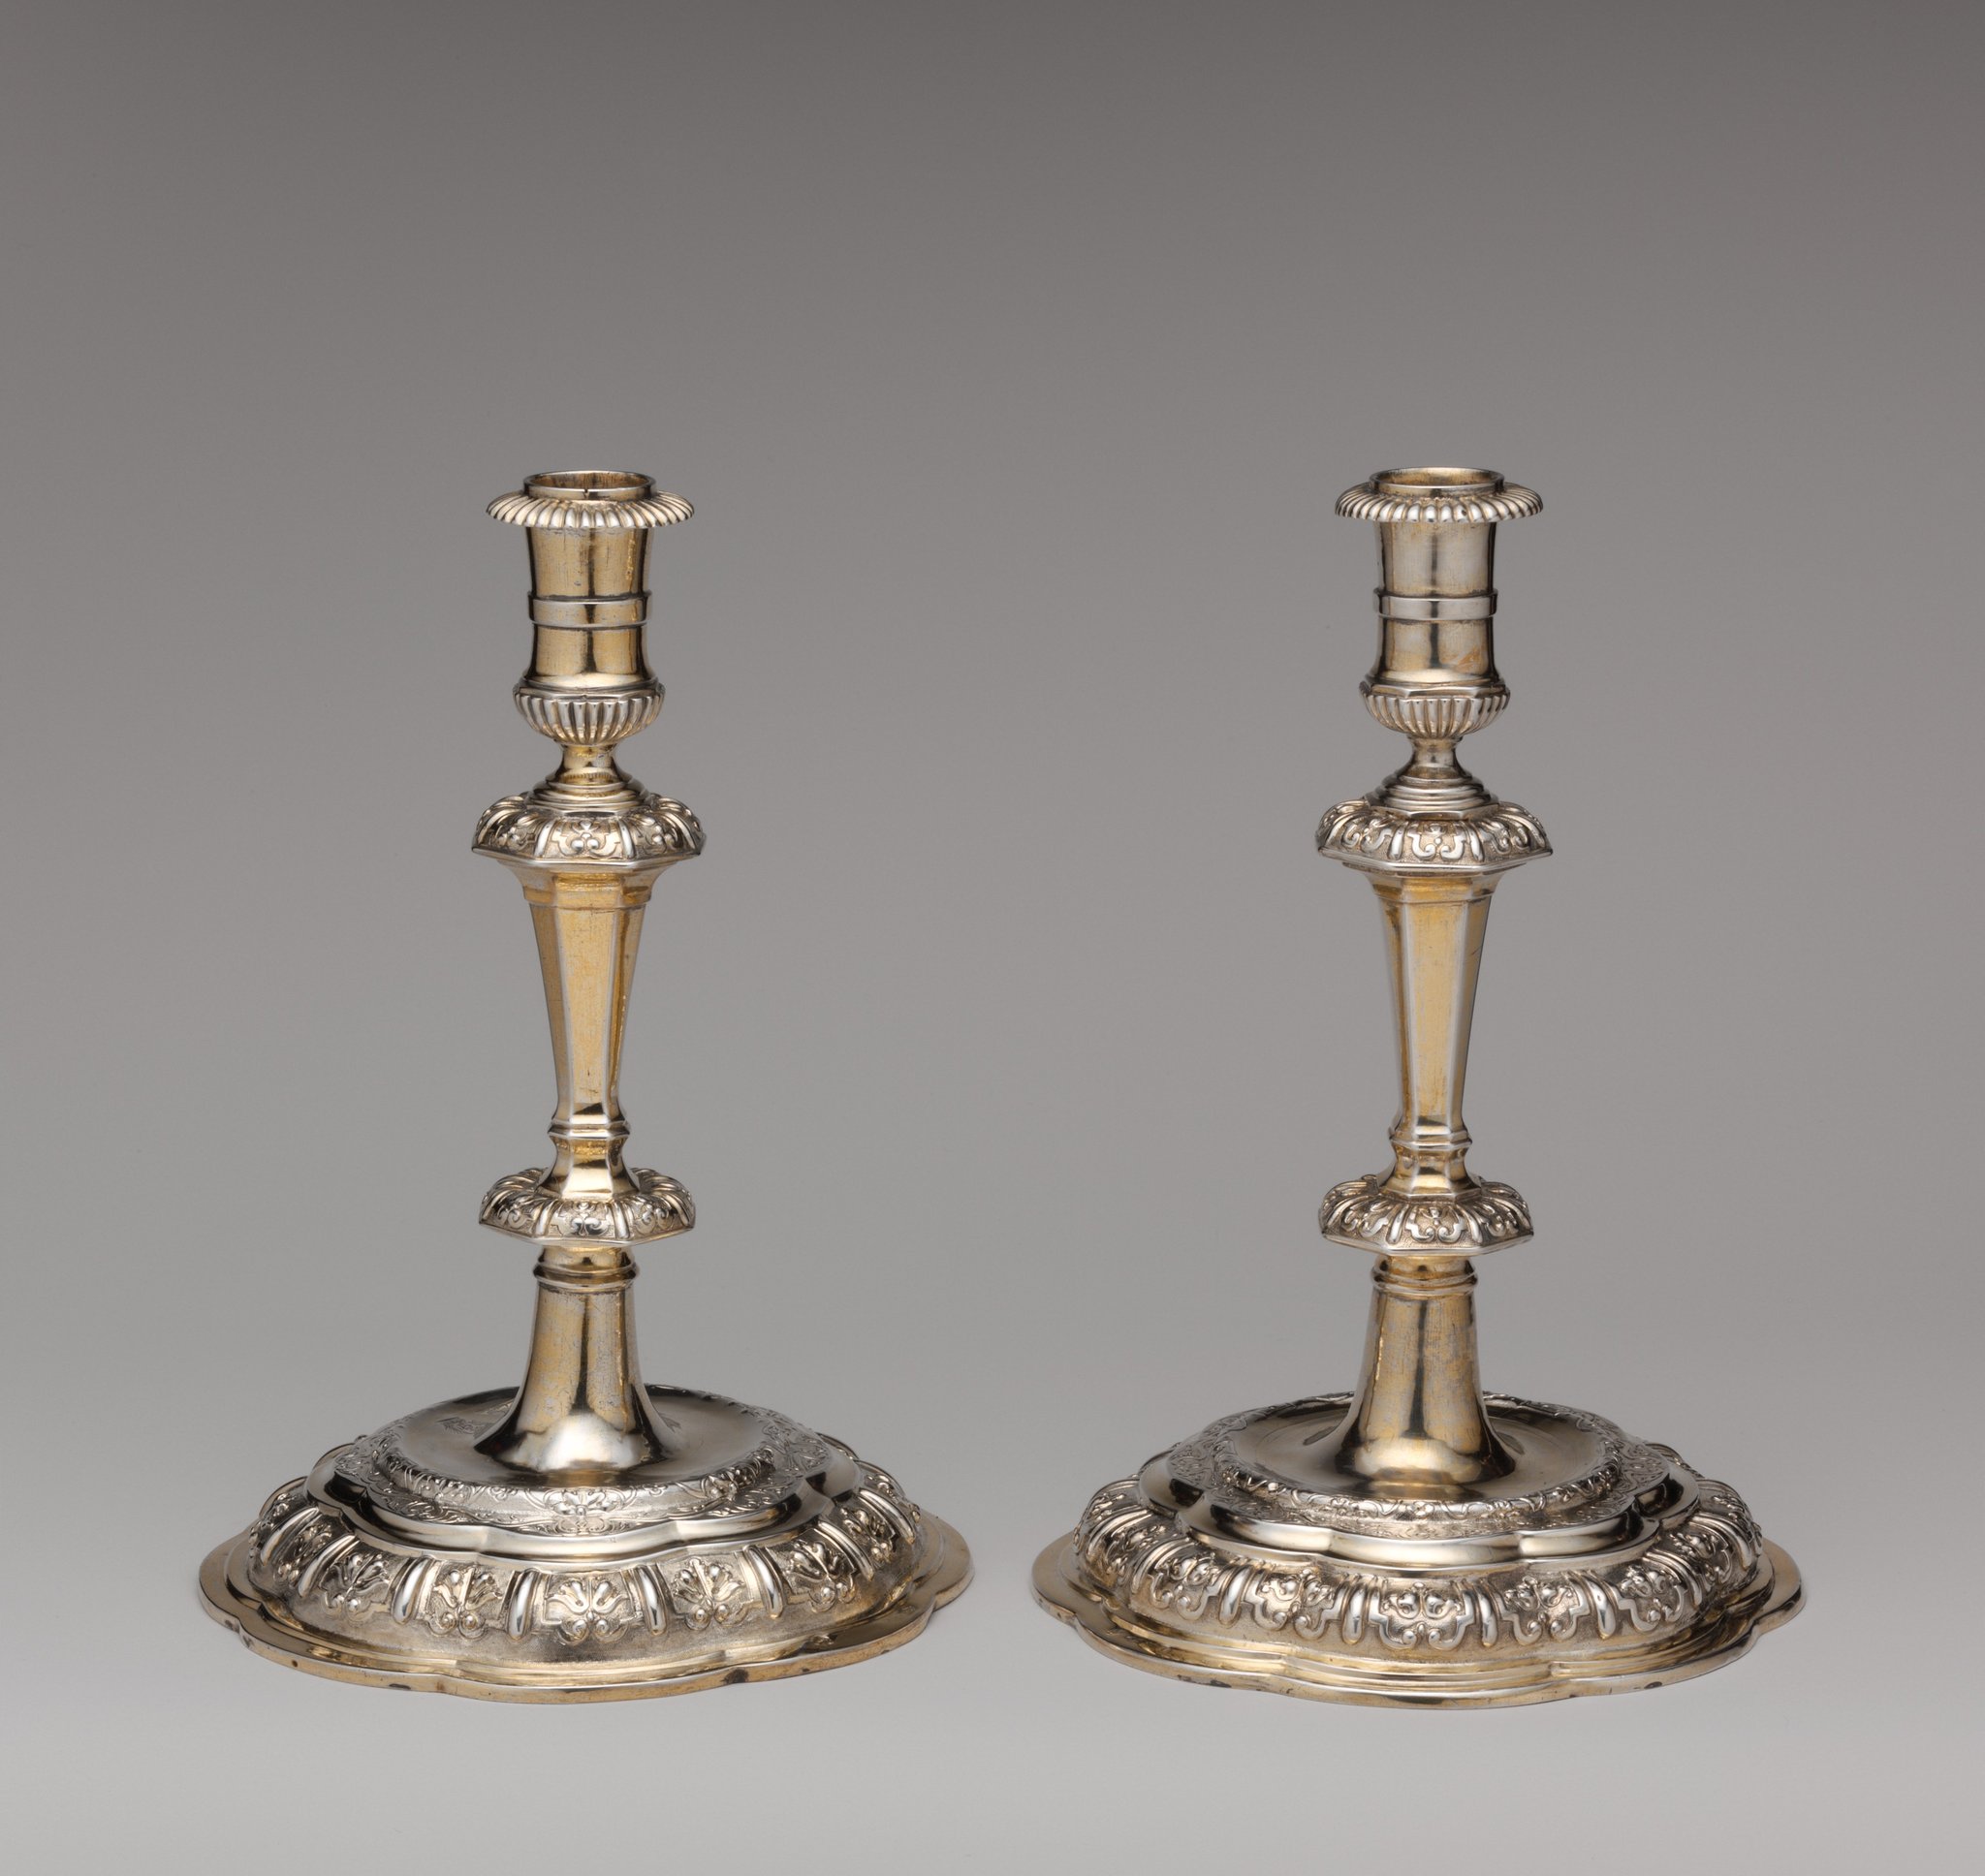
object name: candlestick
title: Candlestick (one of a pair)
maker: master "rw"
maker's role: maker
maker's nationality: swedish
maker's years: 1650-1750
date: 1710-1720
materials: gilt, silver